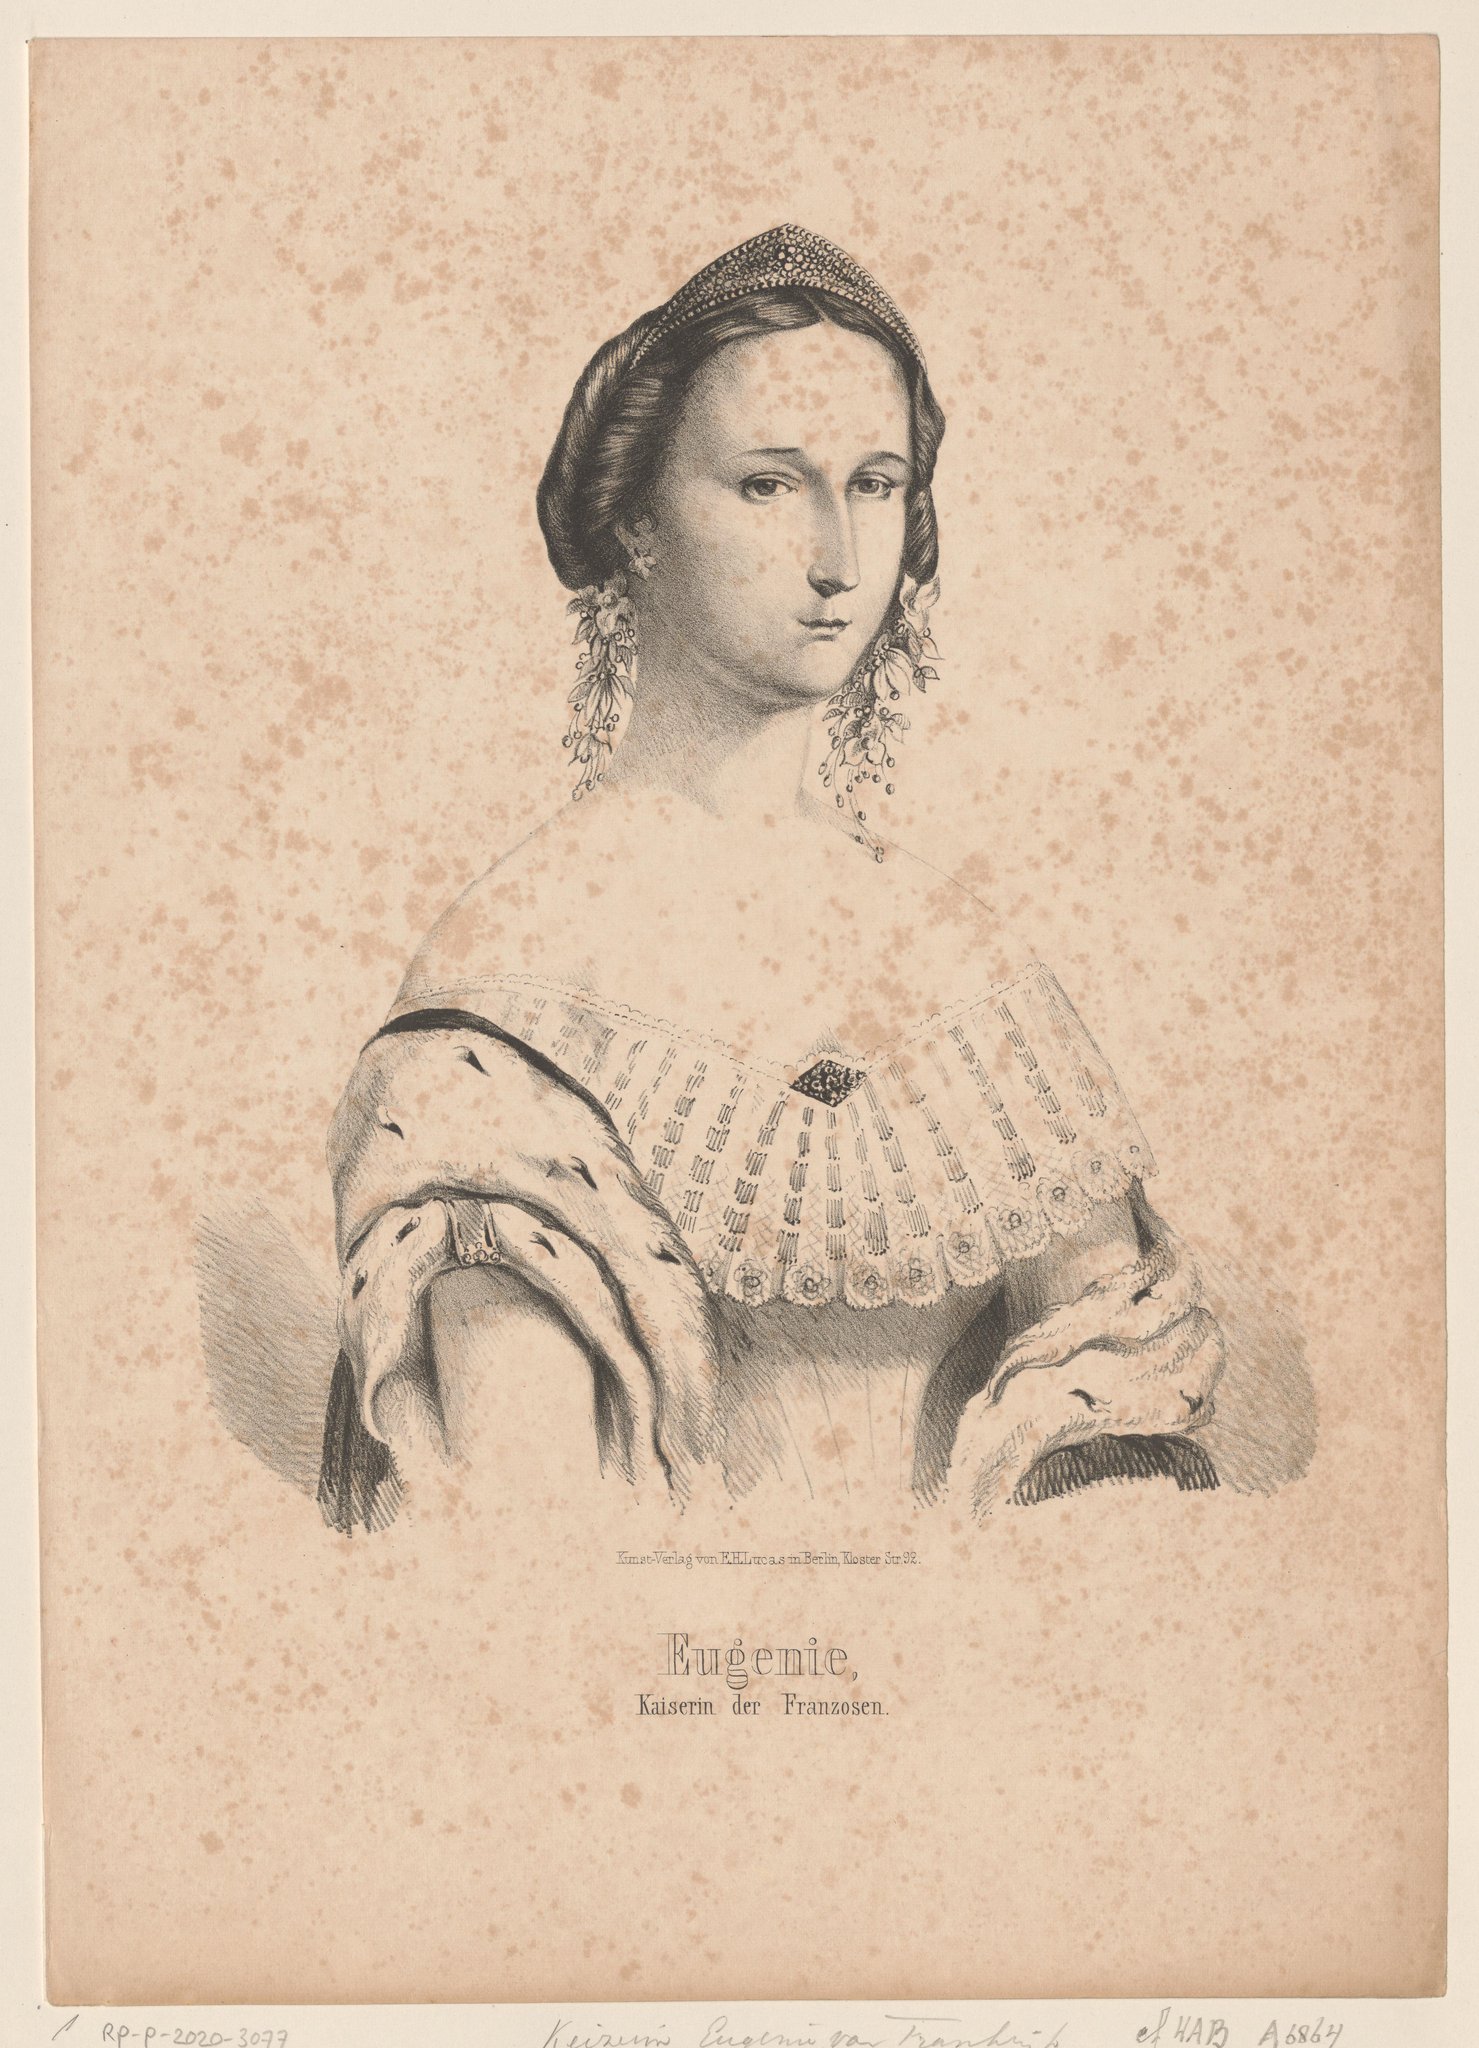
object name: print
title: Portret van Eugénie de Montijo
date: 1853-1900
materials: paper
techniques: lithograph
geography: germany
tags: sevilla, historical persons - bb - woman, diadem (symbol of sovereignty) - bb - female ruler, queen, empress, etc. (wife of a ruler)